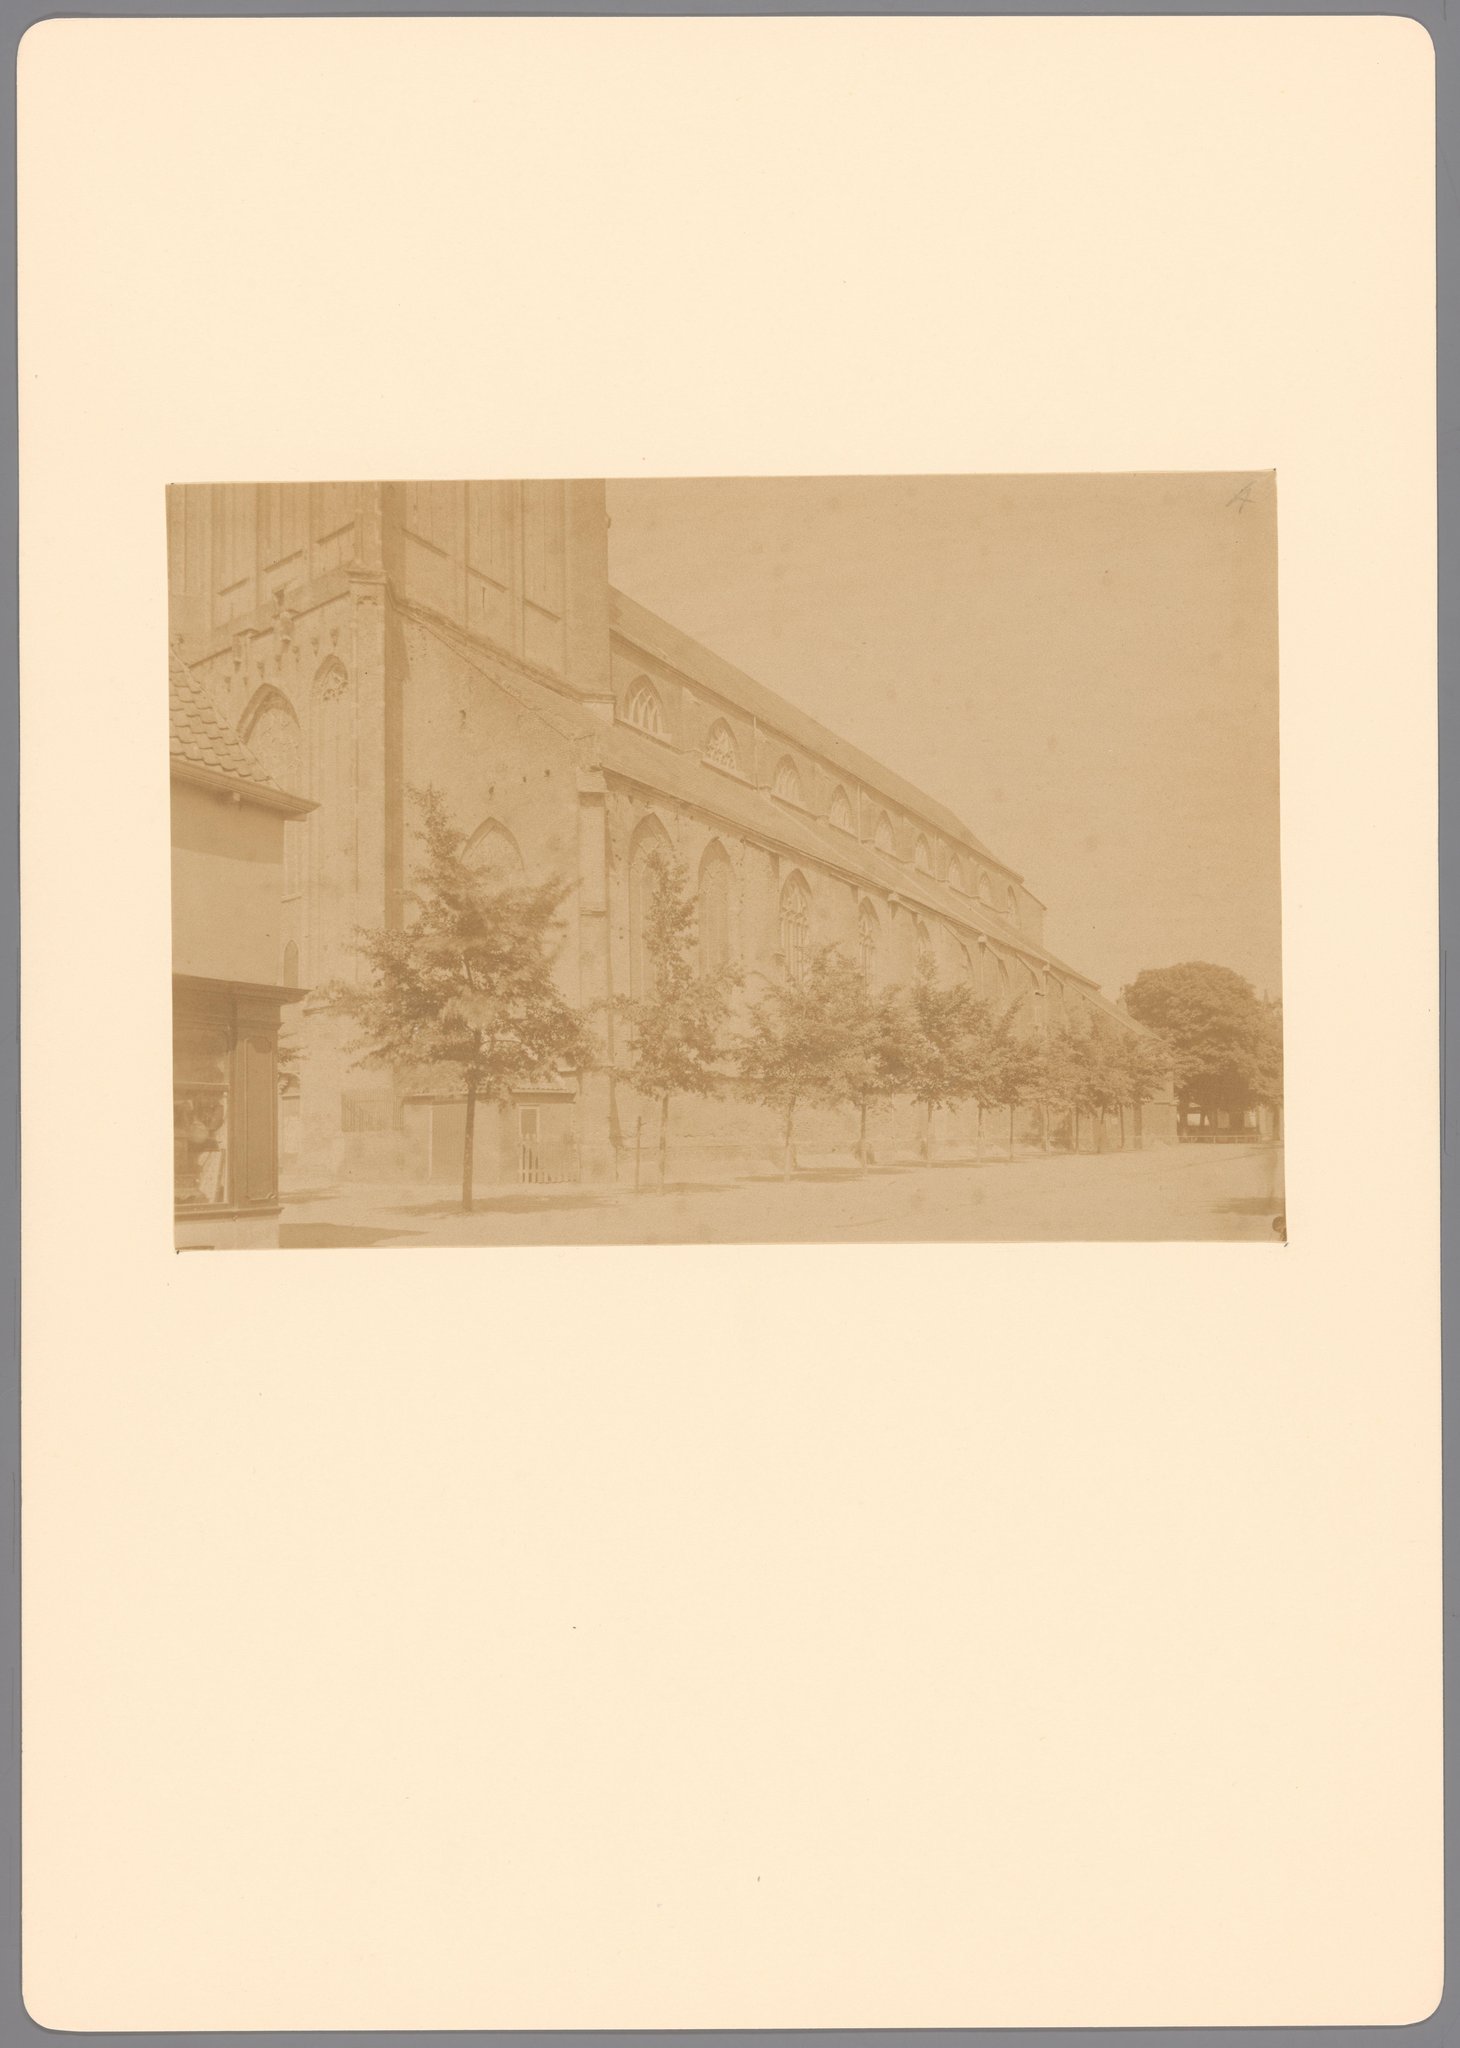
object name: photograph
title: Zuidwestzijde van de Grote of Martinikerk te Doesburg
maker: anoniem (monumentenzorg)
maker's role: fotograaf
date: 1899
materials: cardboard, photographic support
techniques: albumen print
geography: doesburg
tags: church (exterior)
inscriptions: annotation: ‘A’, annotation: ‘Doesburg/ N.H. Kerk’